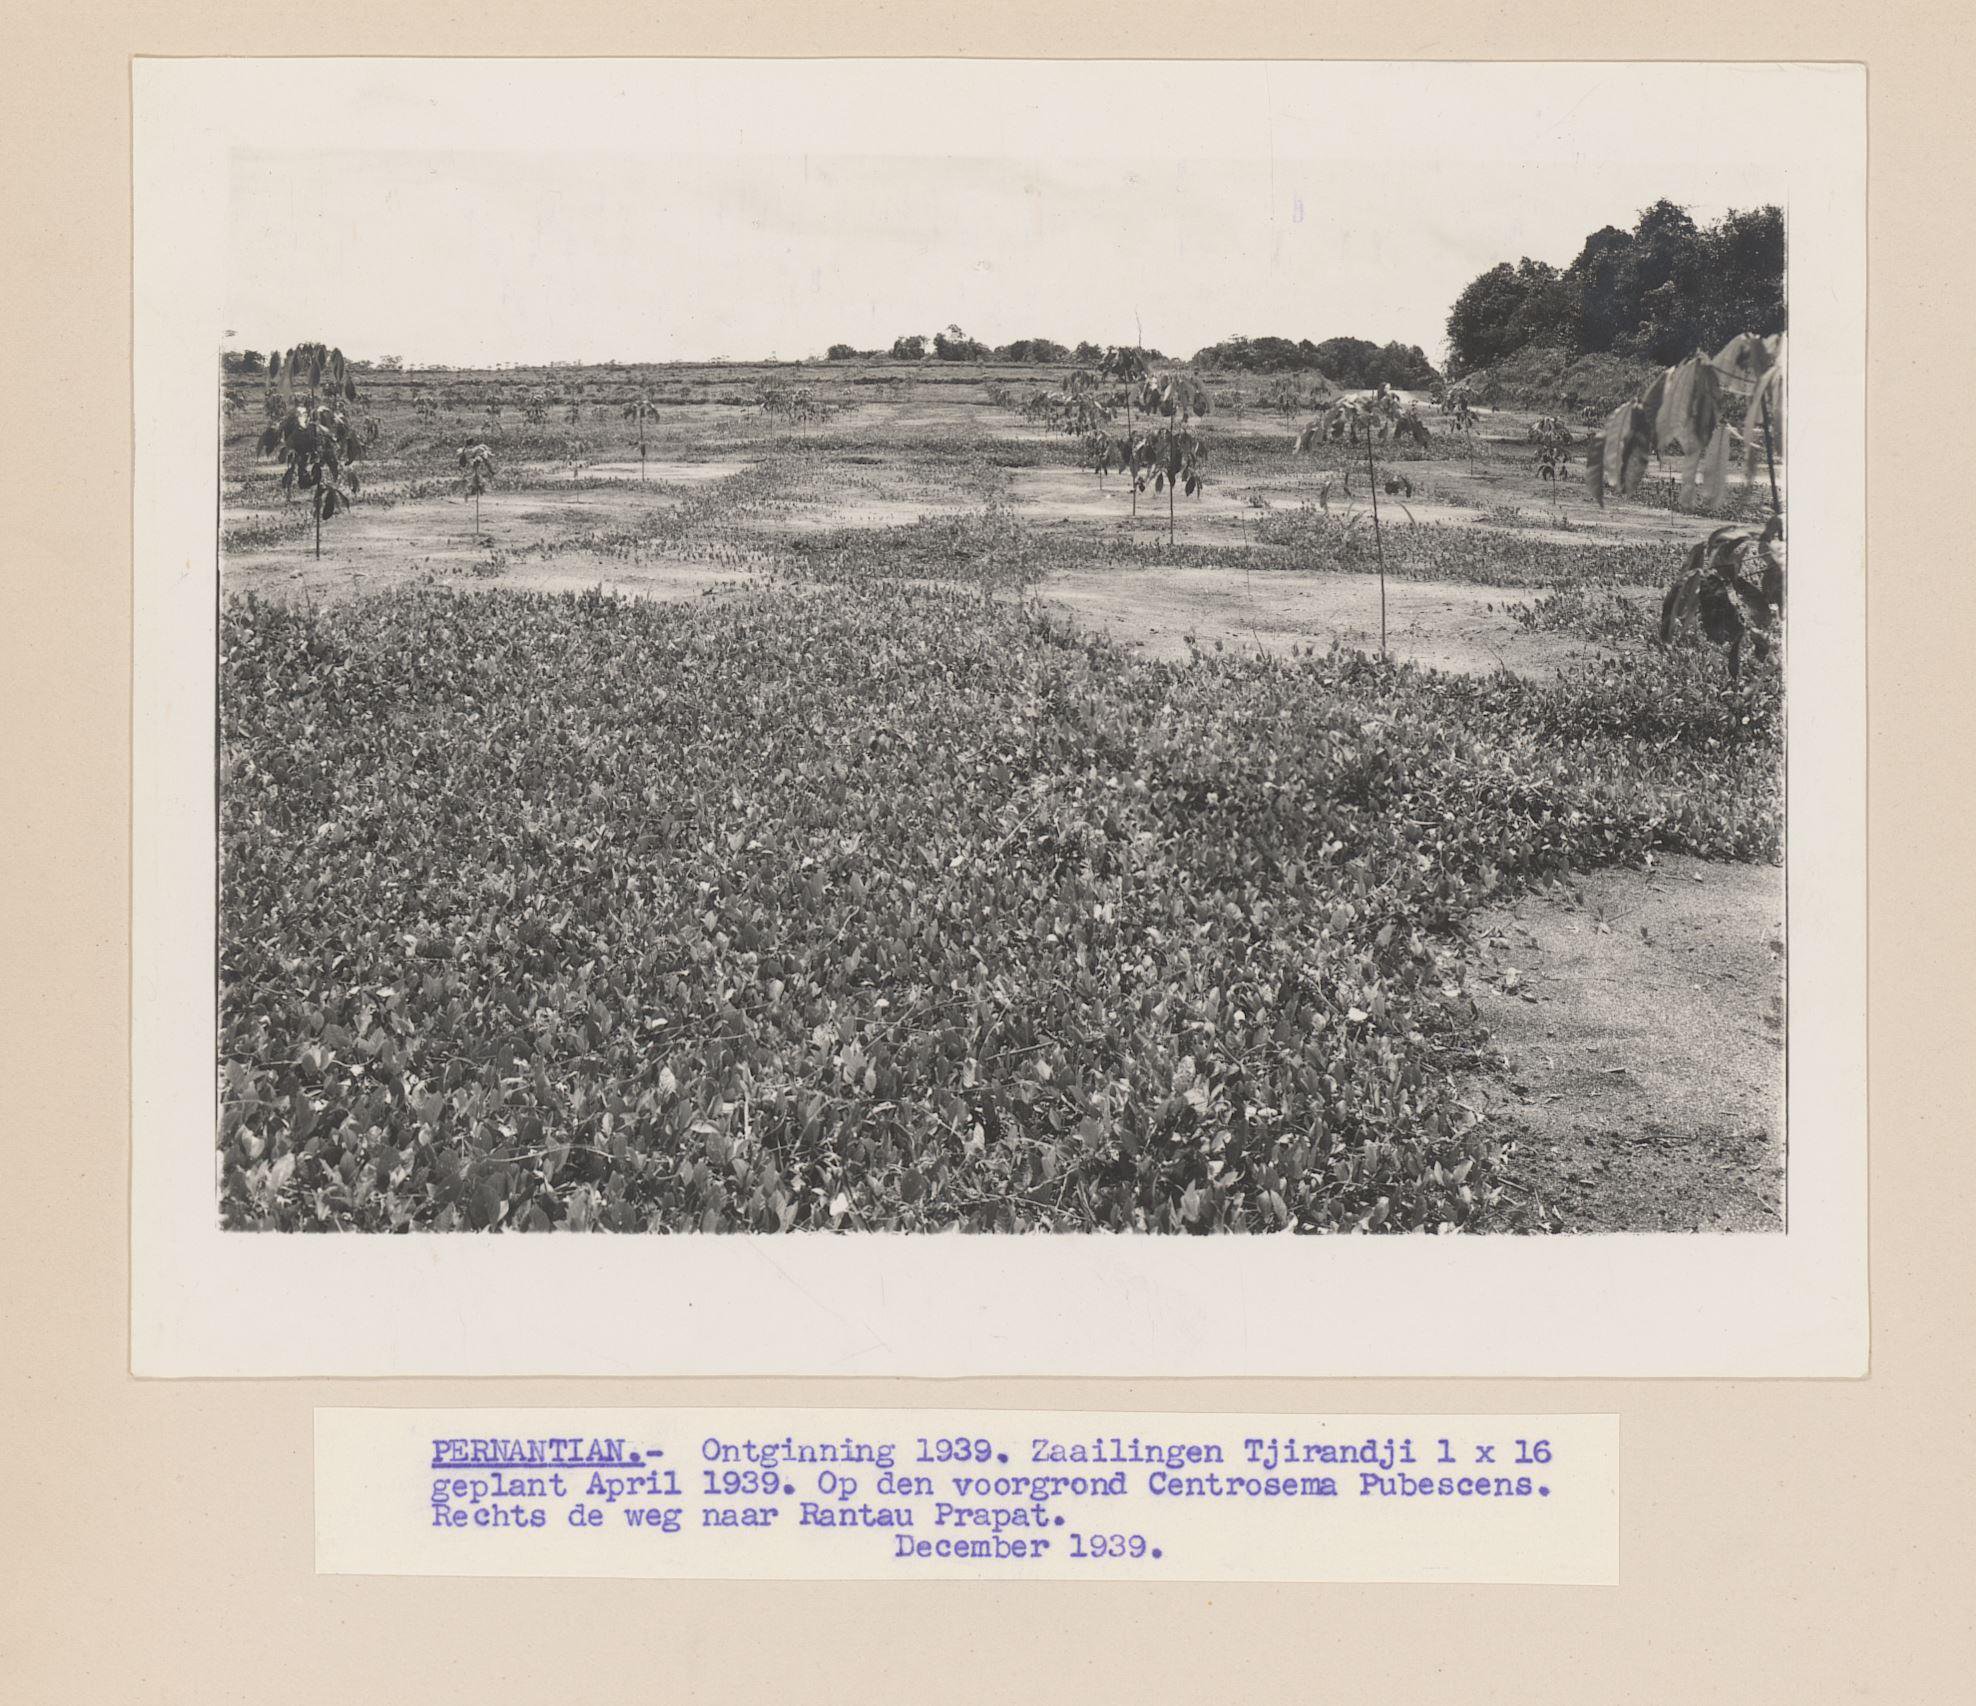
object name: photograph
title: Pernantian - Ontginning 1939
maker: Anonymous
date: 1912-1939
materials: photographic support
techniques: gelatin silver print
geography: sumatra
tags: plantation, (non-fruit) products of plants or trees: rubber, sumatra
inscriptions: inscription: ‘Pernantian - Ontginning 1939, Zaailingen Tjirandji 1 x 16. geplant April 1939. Op den voorgrond Centrosema Pubescens. Rechts de weg naar Rantau Prapat. December 1939.’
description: Ontginning in 1939 van de velden van de plantage Pernantian, december 1939. Nieuwe aanplant van rubberbomen van april 1939, met een aangeplante bodembedekker, rechts de weg naar Rantau Prapat. Onderdeel van het fotoalbum over de plantages Pernantian en Brussel van de Sumatra Caoutchouc Maatschappij op de Oostkust van Sumatra in de jaren 1935-1939.